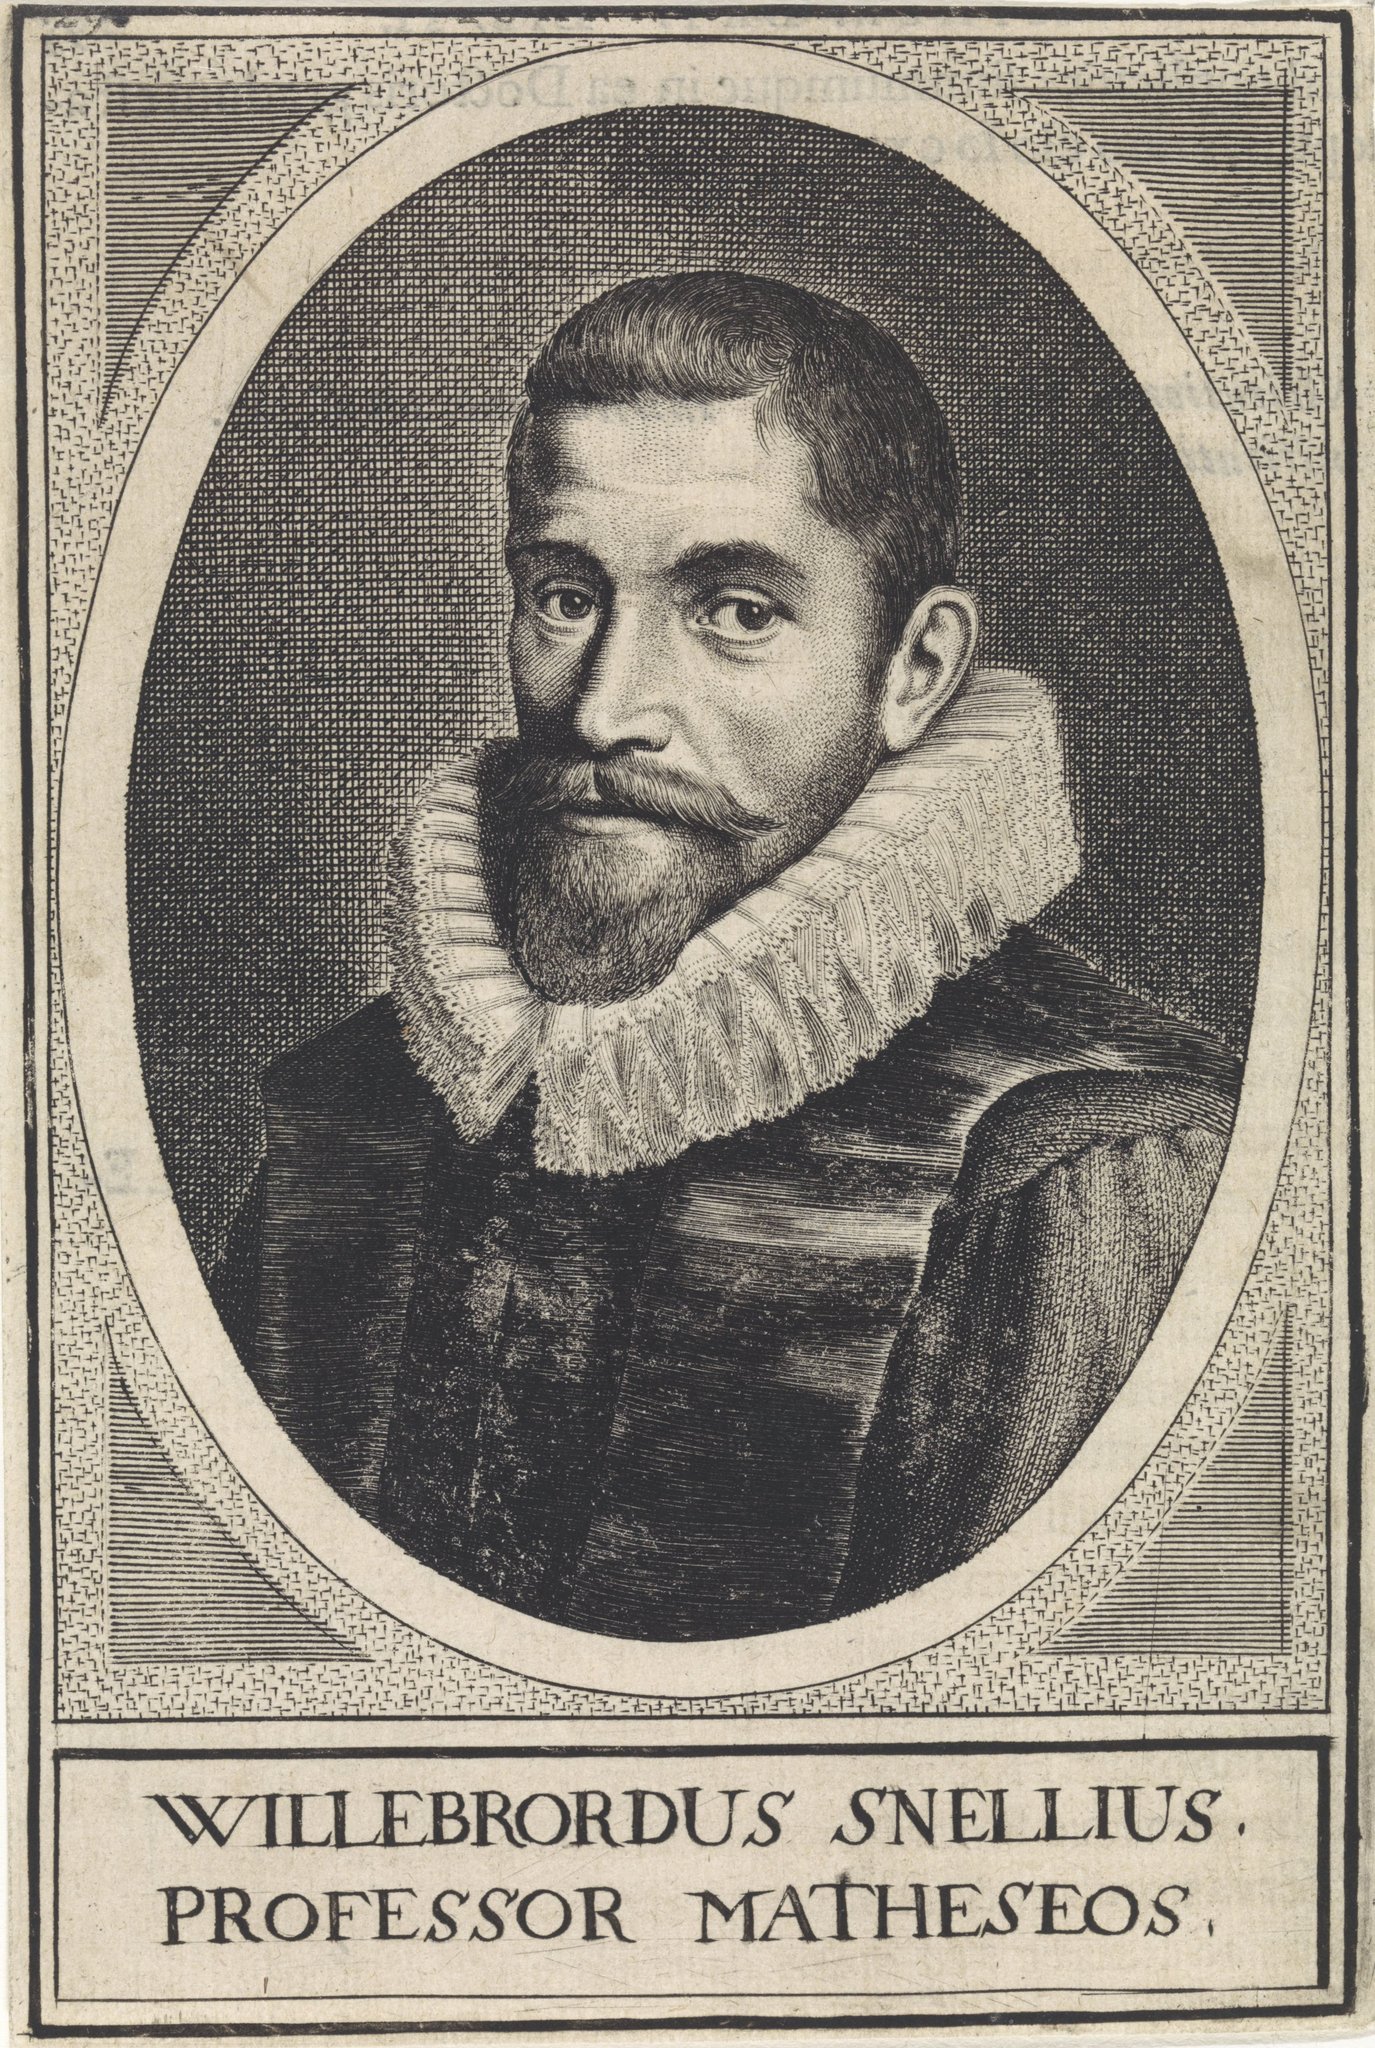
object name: book illustration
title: Portret van Willebrordus Snellius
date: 1625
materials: paper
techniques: engraving, letterpress printing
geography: leiden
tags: leiden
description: Boekillustratie in: Meursius, Joannes. Athenæ Batavæ. Sive, De vrbe Leidensi, & academiâ, virisque claris. Leiden: Andries Clouck, Bonaventura en Abraham Elzevier, 1625. Abusievelijk tweemaal gecatalogiseerd bij Franken & Van der Kellen.